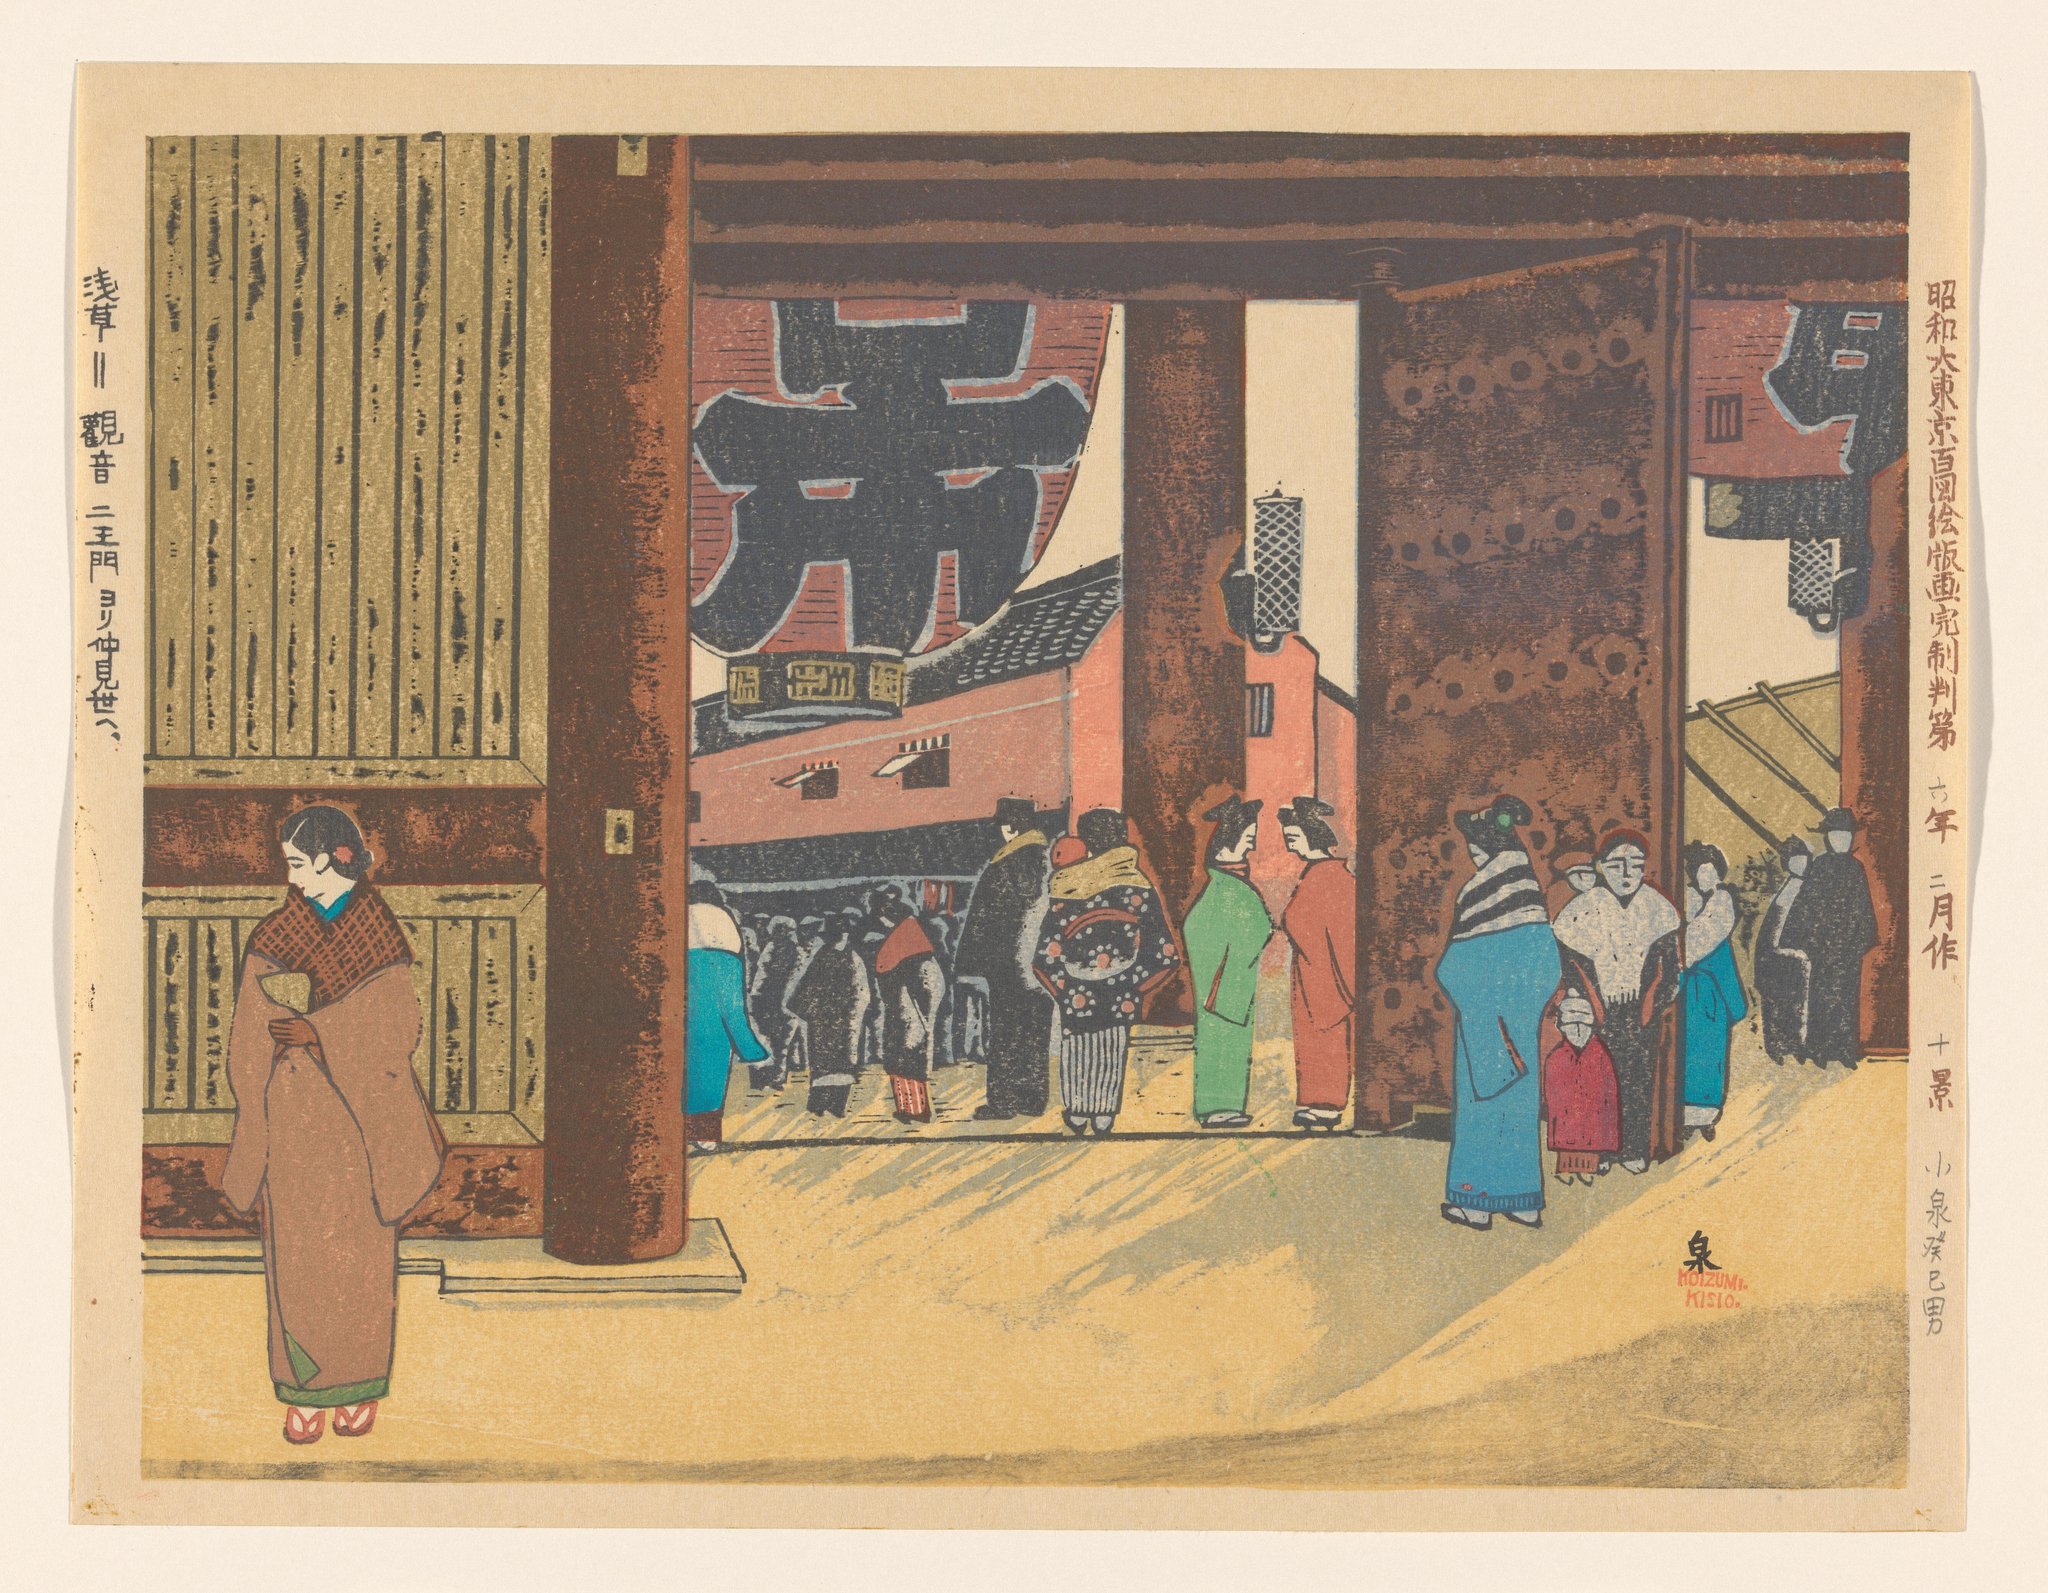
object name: print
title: One hundred pictures of Great Tokyo in the Shōwa era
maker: koizumi kishio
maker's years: 1893-1945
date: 1902-1931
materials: paper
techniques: woodcut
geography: japan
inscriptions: signature: ‘Koizumi Kisio.’, signature: ‘泉’, signature: ‘小泉癸巳男’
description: Een gezicht op de enorme rode poort van de drukbezochte Sensō-tempel in Asakusa, Tokyo. Zichtbaar door de opening van de poort zijn rijen winkeltjes die bekend staan als 'nakamise'. In september 1928 begon Koizumi Kishio aan zijn ambitieuze plan om honderd landschapsprenten met scènes in Tokyo volledig zelf te ontwerpen, hiervan zelf de drukblokken te snijden en zelf de prenten te drukken. De aanleiding voor het project was grote verandering die Tokyo onderging door de verwoestende Grote Kantō-aardbeving van 1923 en de wederopbouw die daarop volgde. Kishio maakt een bewuste verwijzing naar de bekende serie ‘Honderd beroemde gezichten op Edo’ door Utagawa Hiroshige (1797–1858), met prenten van locaties in Edo—de oude benaming voor Tokyo. Kishio toont overwegend moderne gebouwen, instituten en mensen die de tijdsgeest van de jaren 1920 en 1930 weerspiegelen. Sommige prenten onthullen daarentegen een nostalgische blik op overblijfselen uit het oude Edo. Kishio verkocht de prenten aan de hand van een abonnement met een limiet van vijftig leden, die elke maand een of twee prenten zouden ontvangen. Het project begon met negen abonnementen, maar al na de tweede maand werden meerdere daarvan opgezegd en slechts vier mecenassen bleven lid tot en met de voltooiing van de serie. Hij bracht het honderdste ontwerp uit in 1937. Zijn leermeester Ishii Hakutei schreef een inleiding in 1938 die Kishio verwerkte tot een prent en toevoegde aan de set. Tussen 1939 en 1940 maakte hij nog eens negen extra ontwerpen. Met acht van deze ontwerpen verving hij oudere nummers uit de serie, mogelijk omdat hij niet tevreden was met de composities. Uiteindelijk lukte het Kishio om tien complete sets te verkopen aan de shin hanga-uitgever Watanabe Shōzaburō en liet hiervoor speciale houten dozen maken. Deze prent behoort tot een van die tien sets.